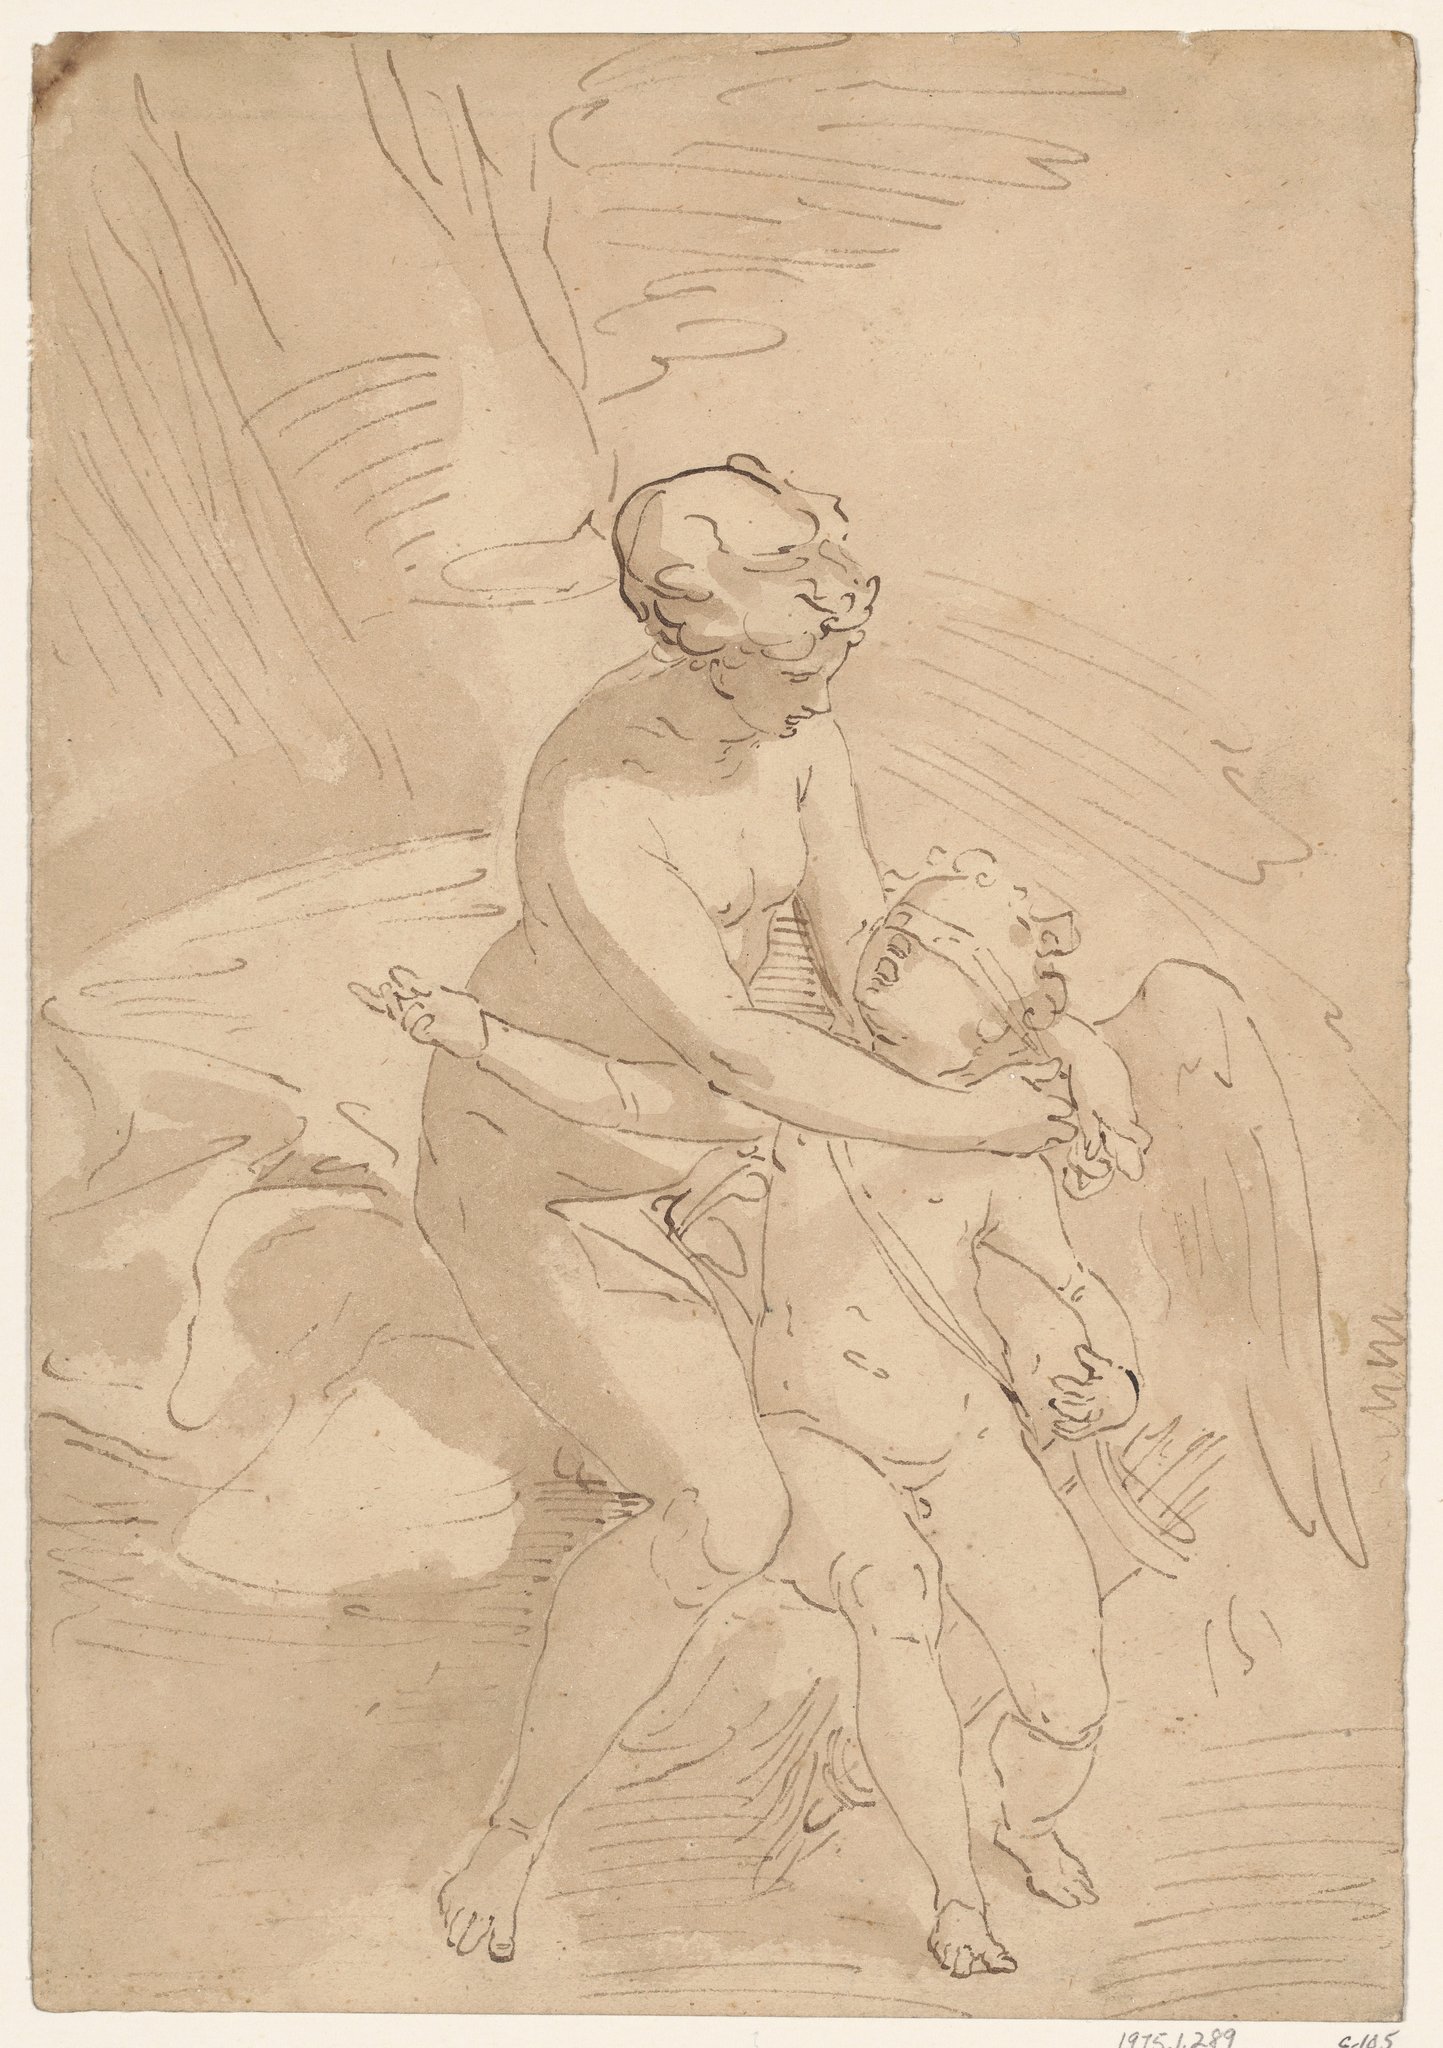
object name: drawing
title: Venus Blindfolding Cupid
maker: school of cambiaso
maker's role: artist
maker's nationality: italian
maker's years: 1527-1585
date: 1567-1600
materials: ink, paper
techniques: pen, wash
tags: cupid,venus